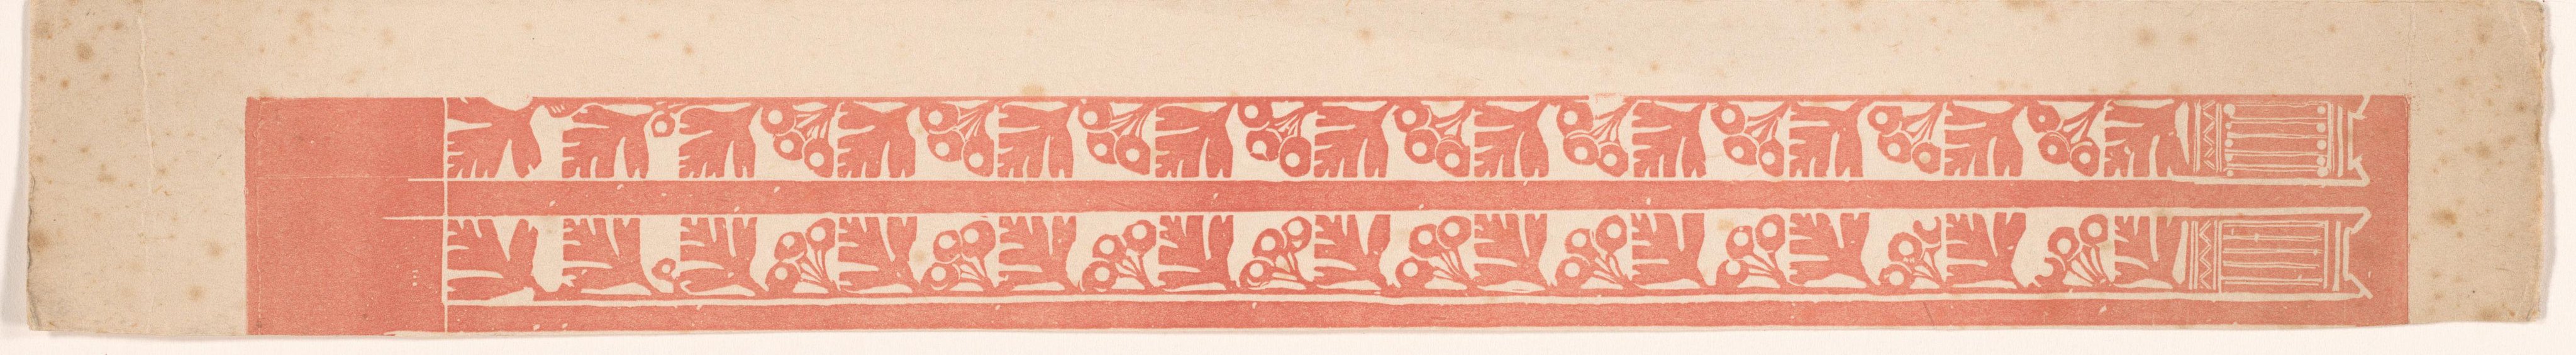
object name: boekillustratie ontwerp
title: Ornament met planten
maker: bernard willem wierink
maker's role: draughtsman, print maker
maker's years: 1856-1939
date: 1910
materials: paper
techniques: relief print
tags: ornaments ~ art, fable of reynard the fox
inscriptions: collector's mark: Lugt 2228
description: Ontwerp voor: Streuvels, Stijn (Frank Lateur). Reinaert de Vos naar verschillende uitgaven van het middeleeuwsche epos. Amsterdam: L.J. Veen, 1910. Deze prent is vermoedelijk een plaatsnede, ook al wordt in de literatuur veelal gesproken over een houtsnede. Voor zover Wierink zijn prenten in hoogdruk zelf nader heeft omschreven, heeft hij altijd de term 'plaatsnede' gebruikt.